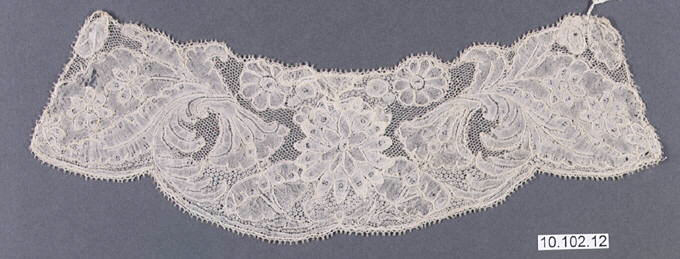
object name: flounce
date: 1701-1733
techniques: lace